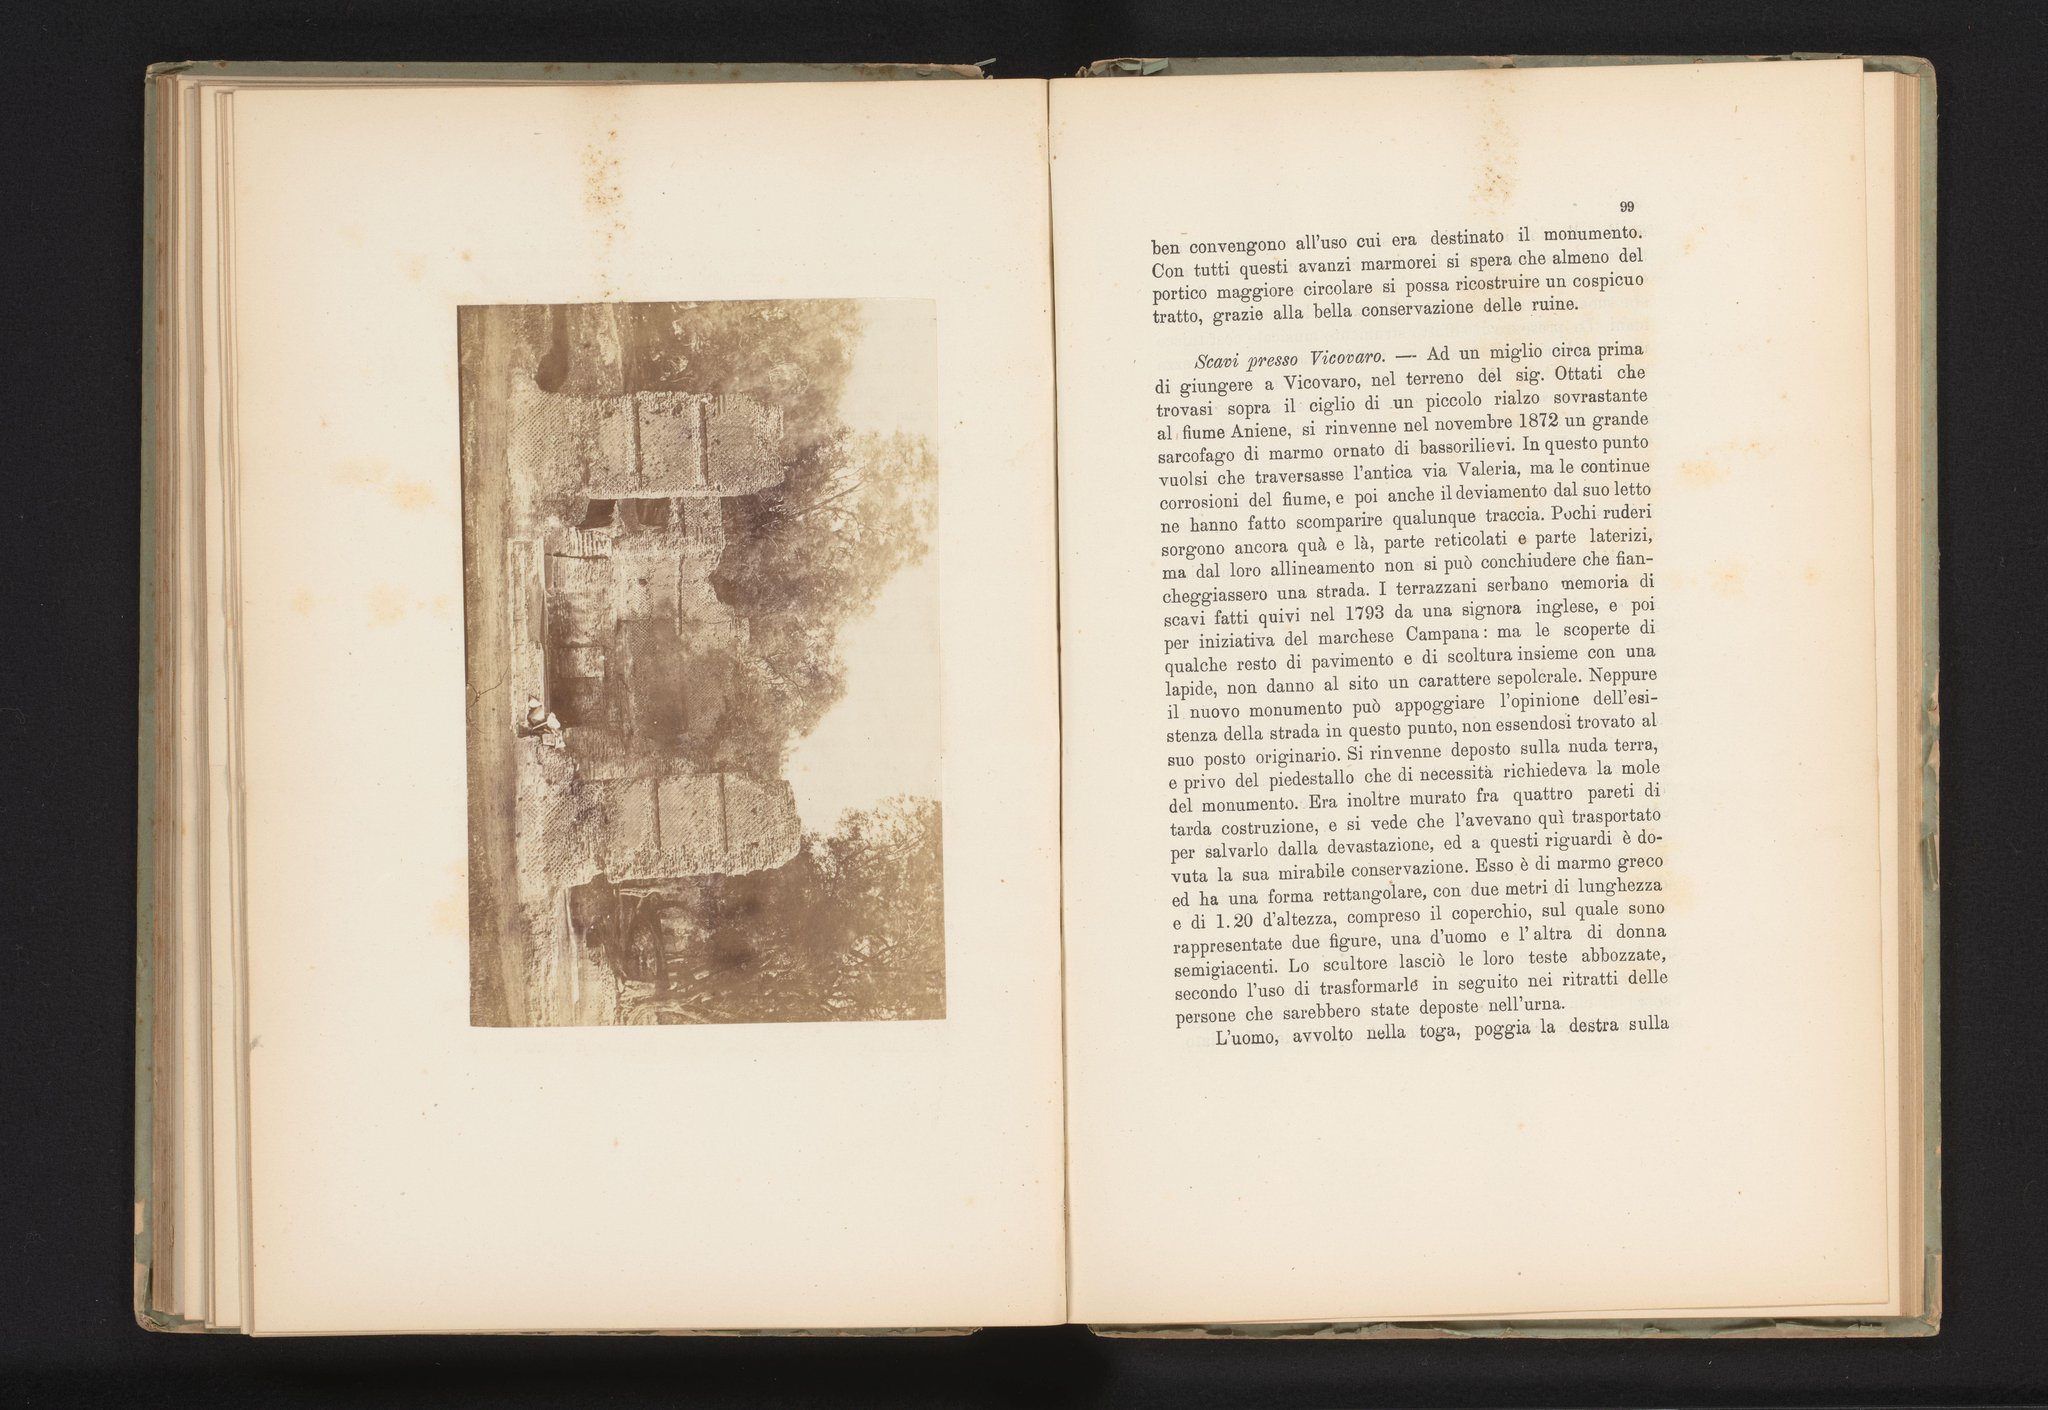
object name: photograph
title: Ruïnes (vermoedelijk) nabij Vicovaro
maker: Anonymous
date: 1863-1873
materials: photographic support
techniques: albumen print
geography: lazio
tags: ruin of a building ~ architecture